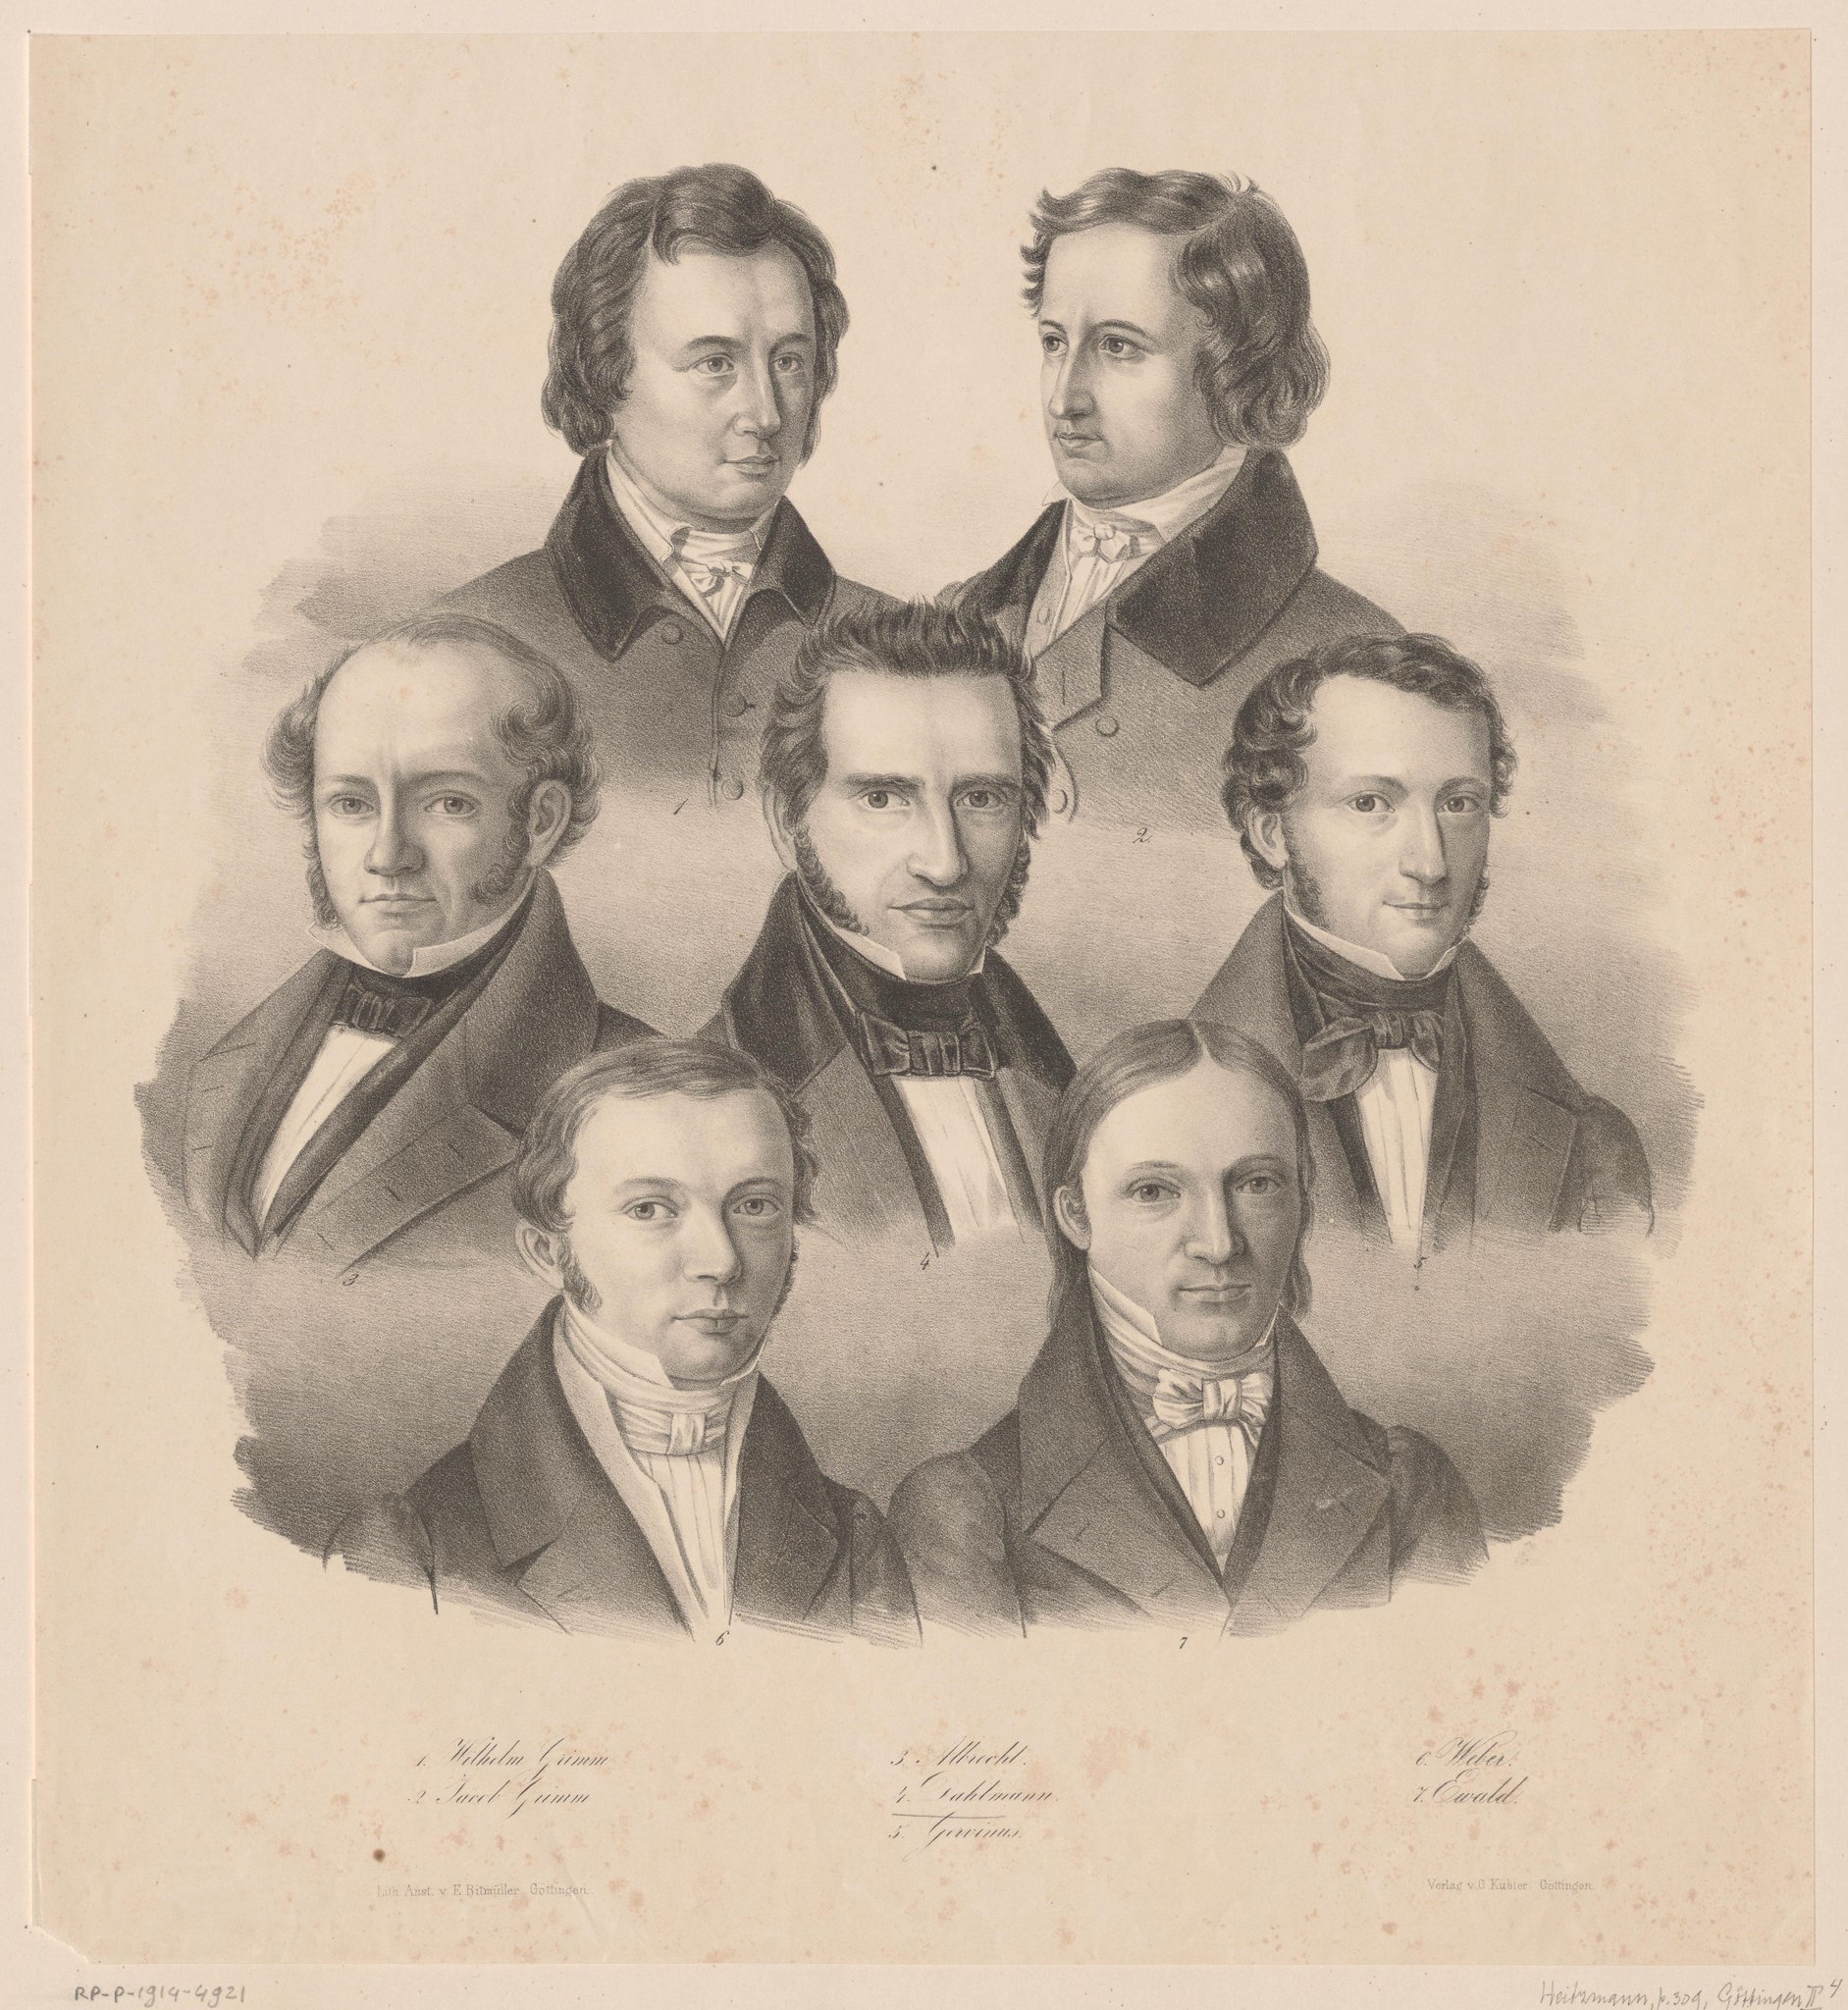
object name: print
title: Portretten van de Göttinger Sieben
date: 1837-1869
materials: paper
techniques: lithograph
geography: gottingen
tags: berlin, jacob ludwig karl grimm, physicist, historical persons, portrait of a writer, politician, e.g. party leader, professor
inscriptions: collector's mark: Lugt 2228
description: Portretten van zeven Duitse hoogleraren met de namen Wilhelm Karl Grimm, Jacob Ludwig Karl Grimm, Wilhelm Eduard Albrecht, Friedrich Christoph Dahlmann, Georg Gottfried Gervinus, Wilhelm Eduard Weber, Heinrich Ewald. Vanwege hun protest tegen het opheffen van de vrijzinnige grondwet in 1837 werden zij ontslagen of verbannen. Samen worden zij ook wel de Göttinger Sieben genoemd.